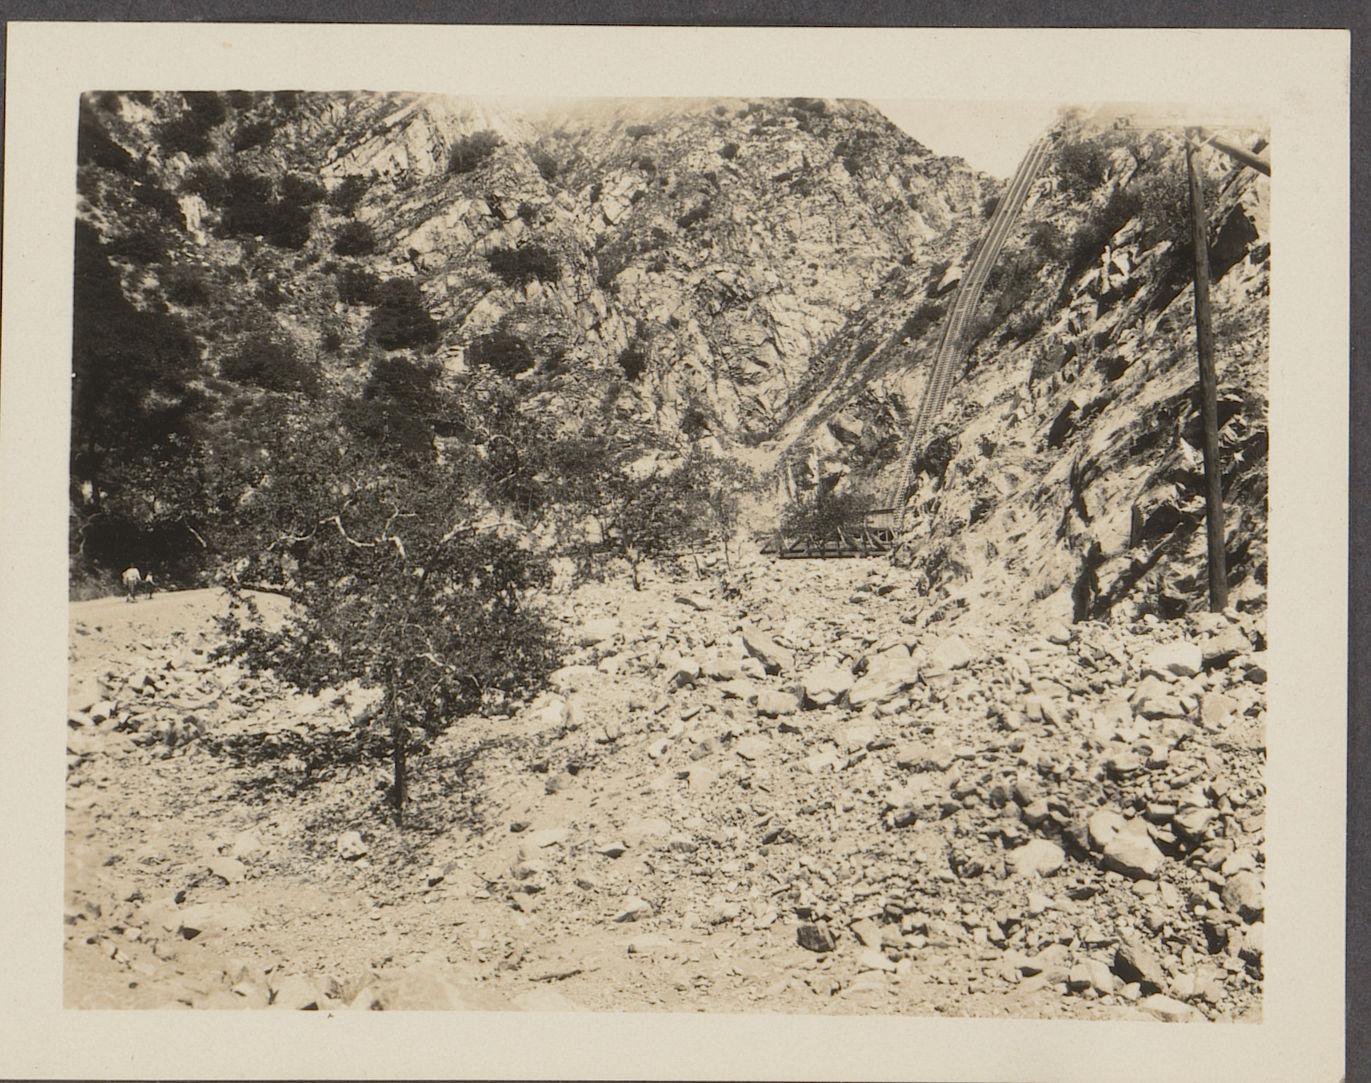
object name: photograph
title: Pacoima Dam in aanbouw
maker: Anonymous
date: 1928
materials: photographic support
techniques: gelatin silver print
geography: los angeles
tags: machines; parts of machines; tools and appliances, dam (in canal)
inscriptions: annotation: ‘Pacoima dam beton transportbaan’